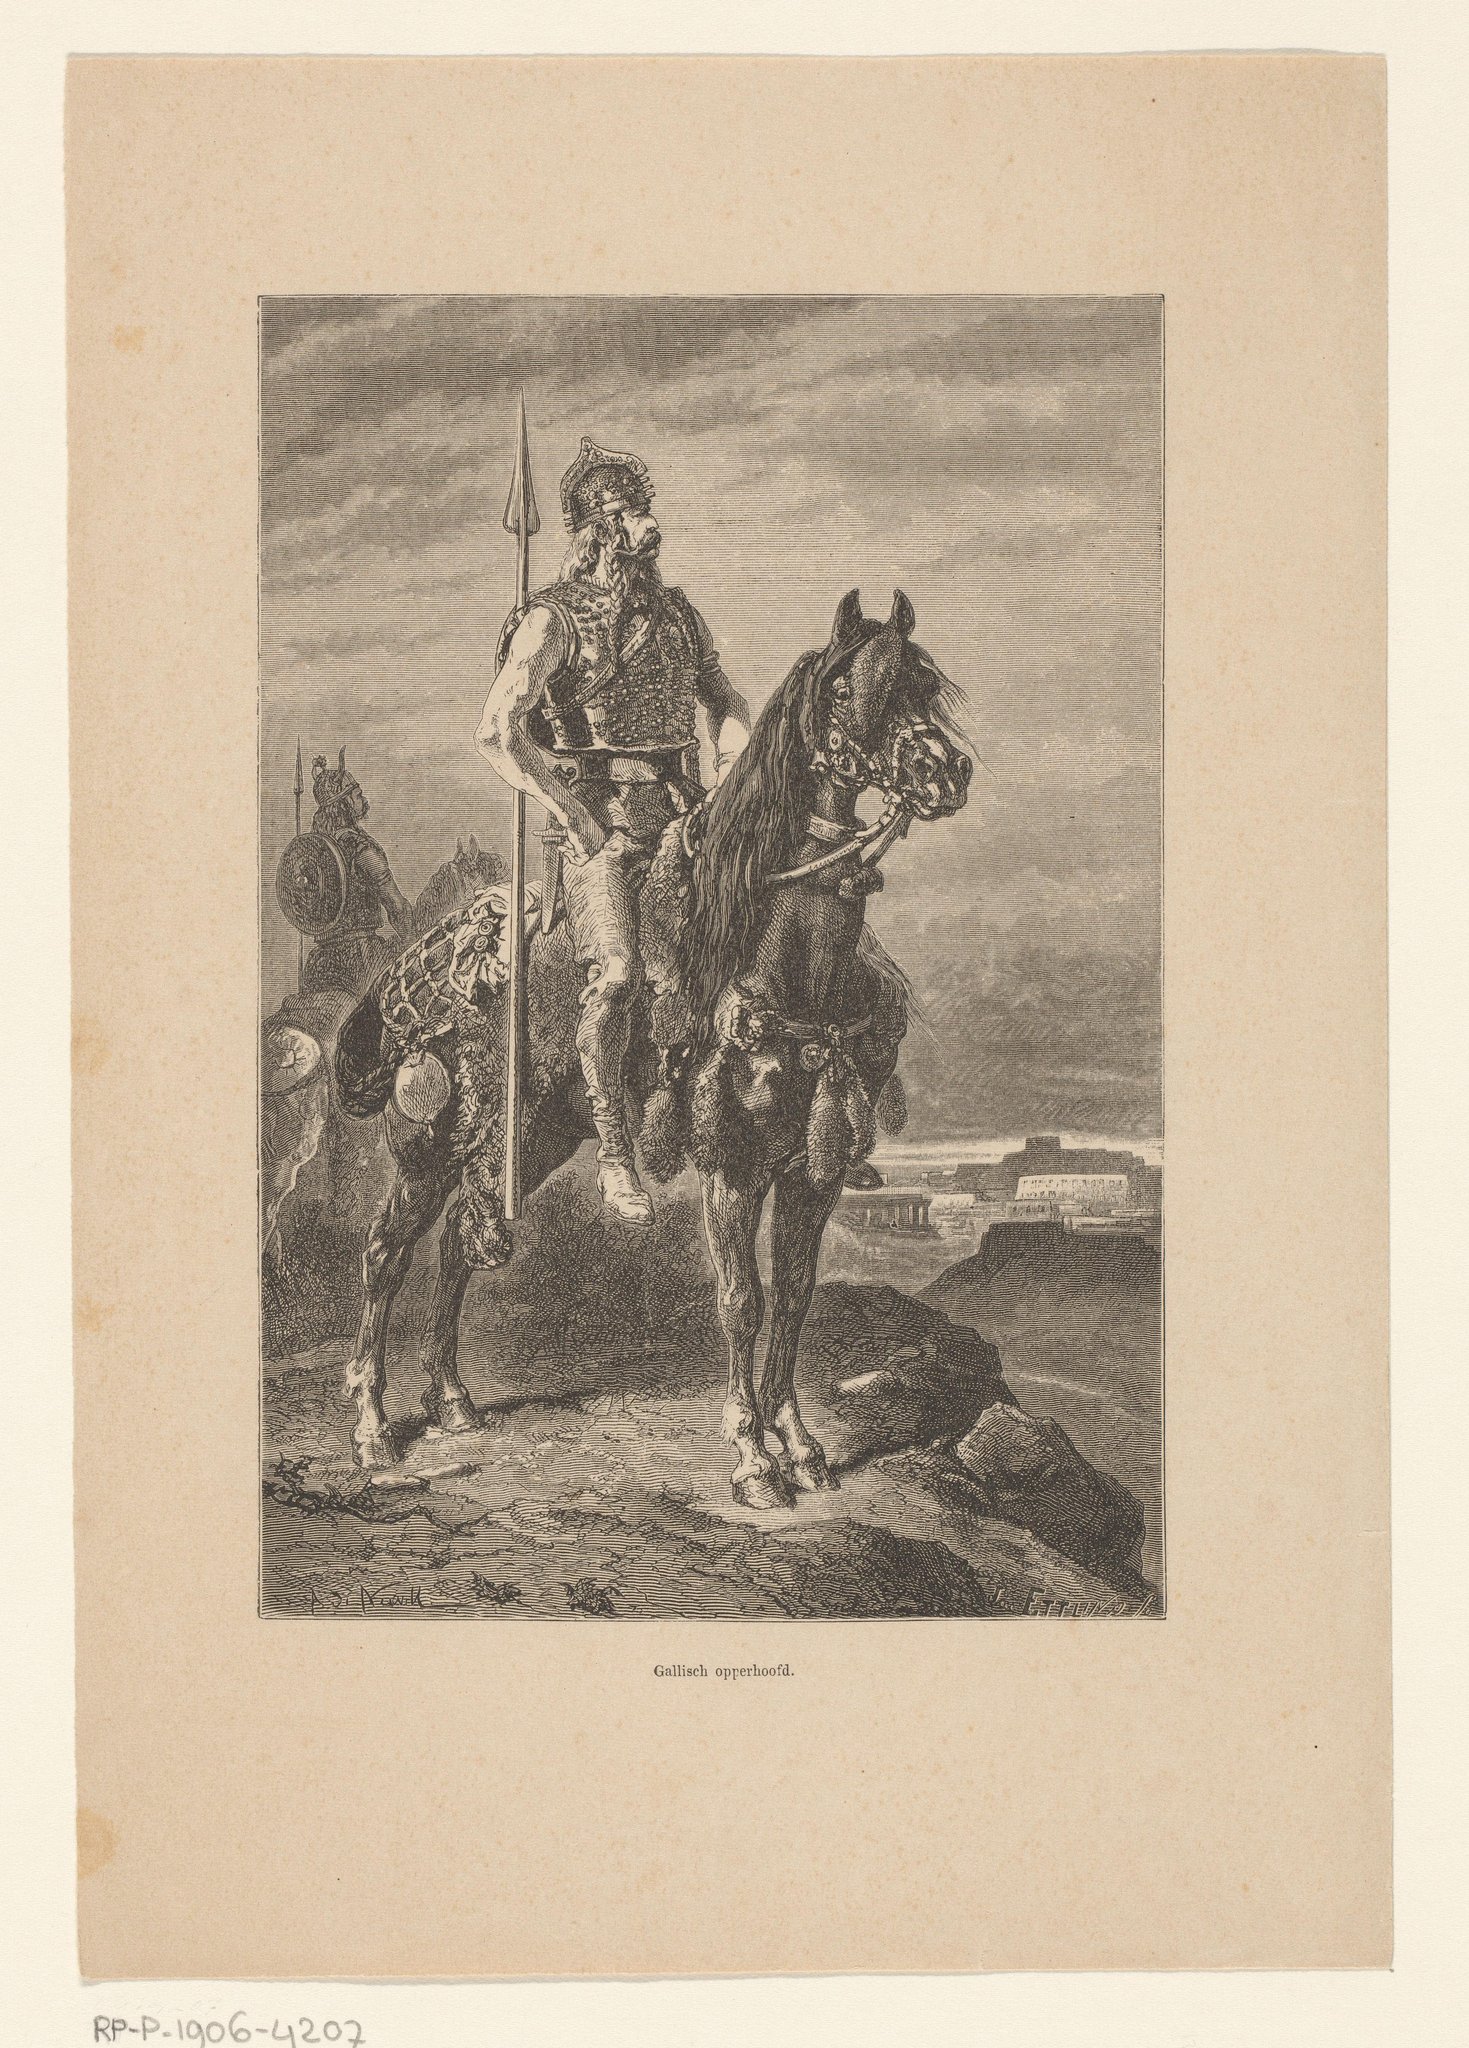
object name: print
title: Galliër op paard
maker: jacques ettling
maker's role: print maker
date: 1850-1900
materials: paper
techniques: engraving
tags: riding a horse, ass, or mule; rider, horseman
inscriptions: collector's mark: Lugt 2228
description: Op het verso een intekenbiljet voor 'Guizot's Geschiedenis van Frankrijk'.